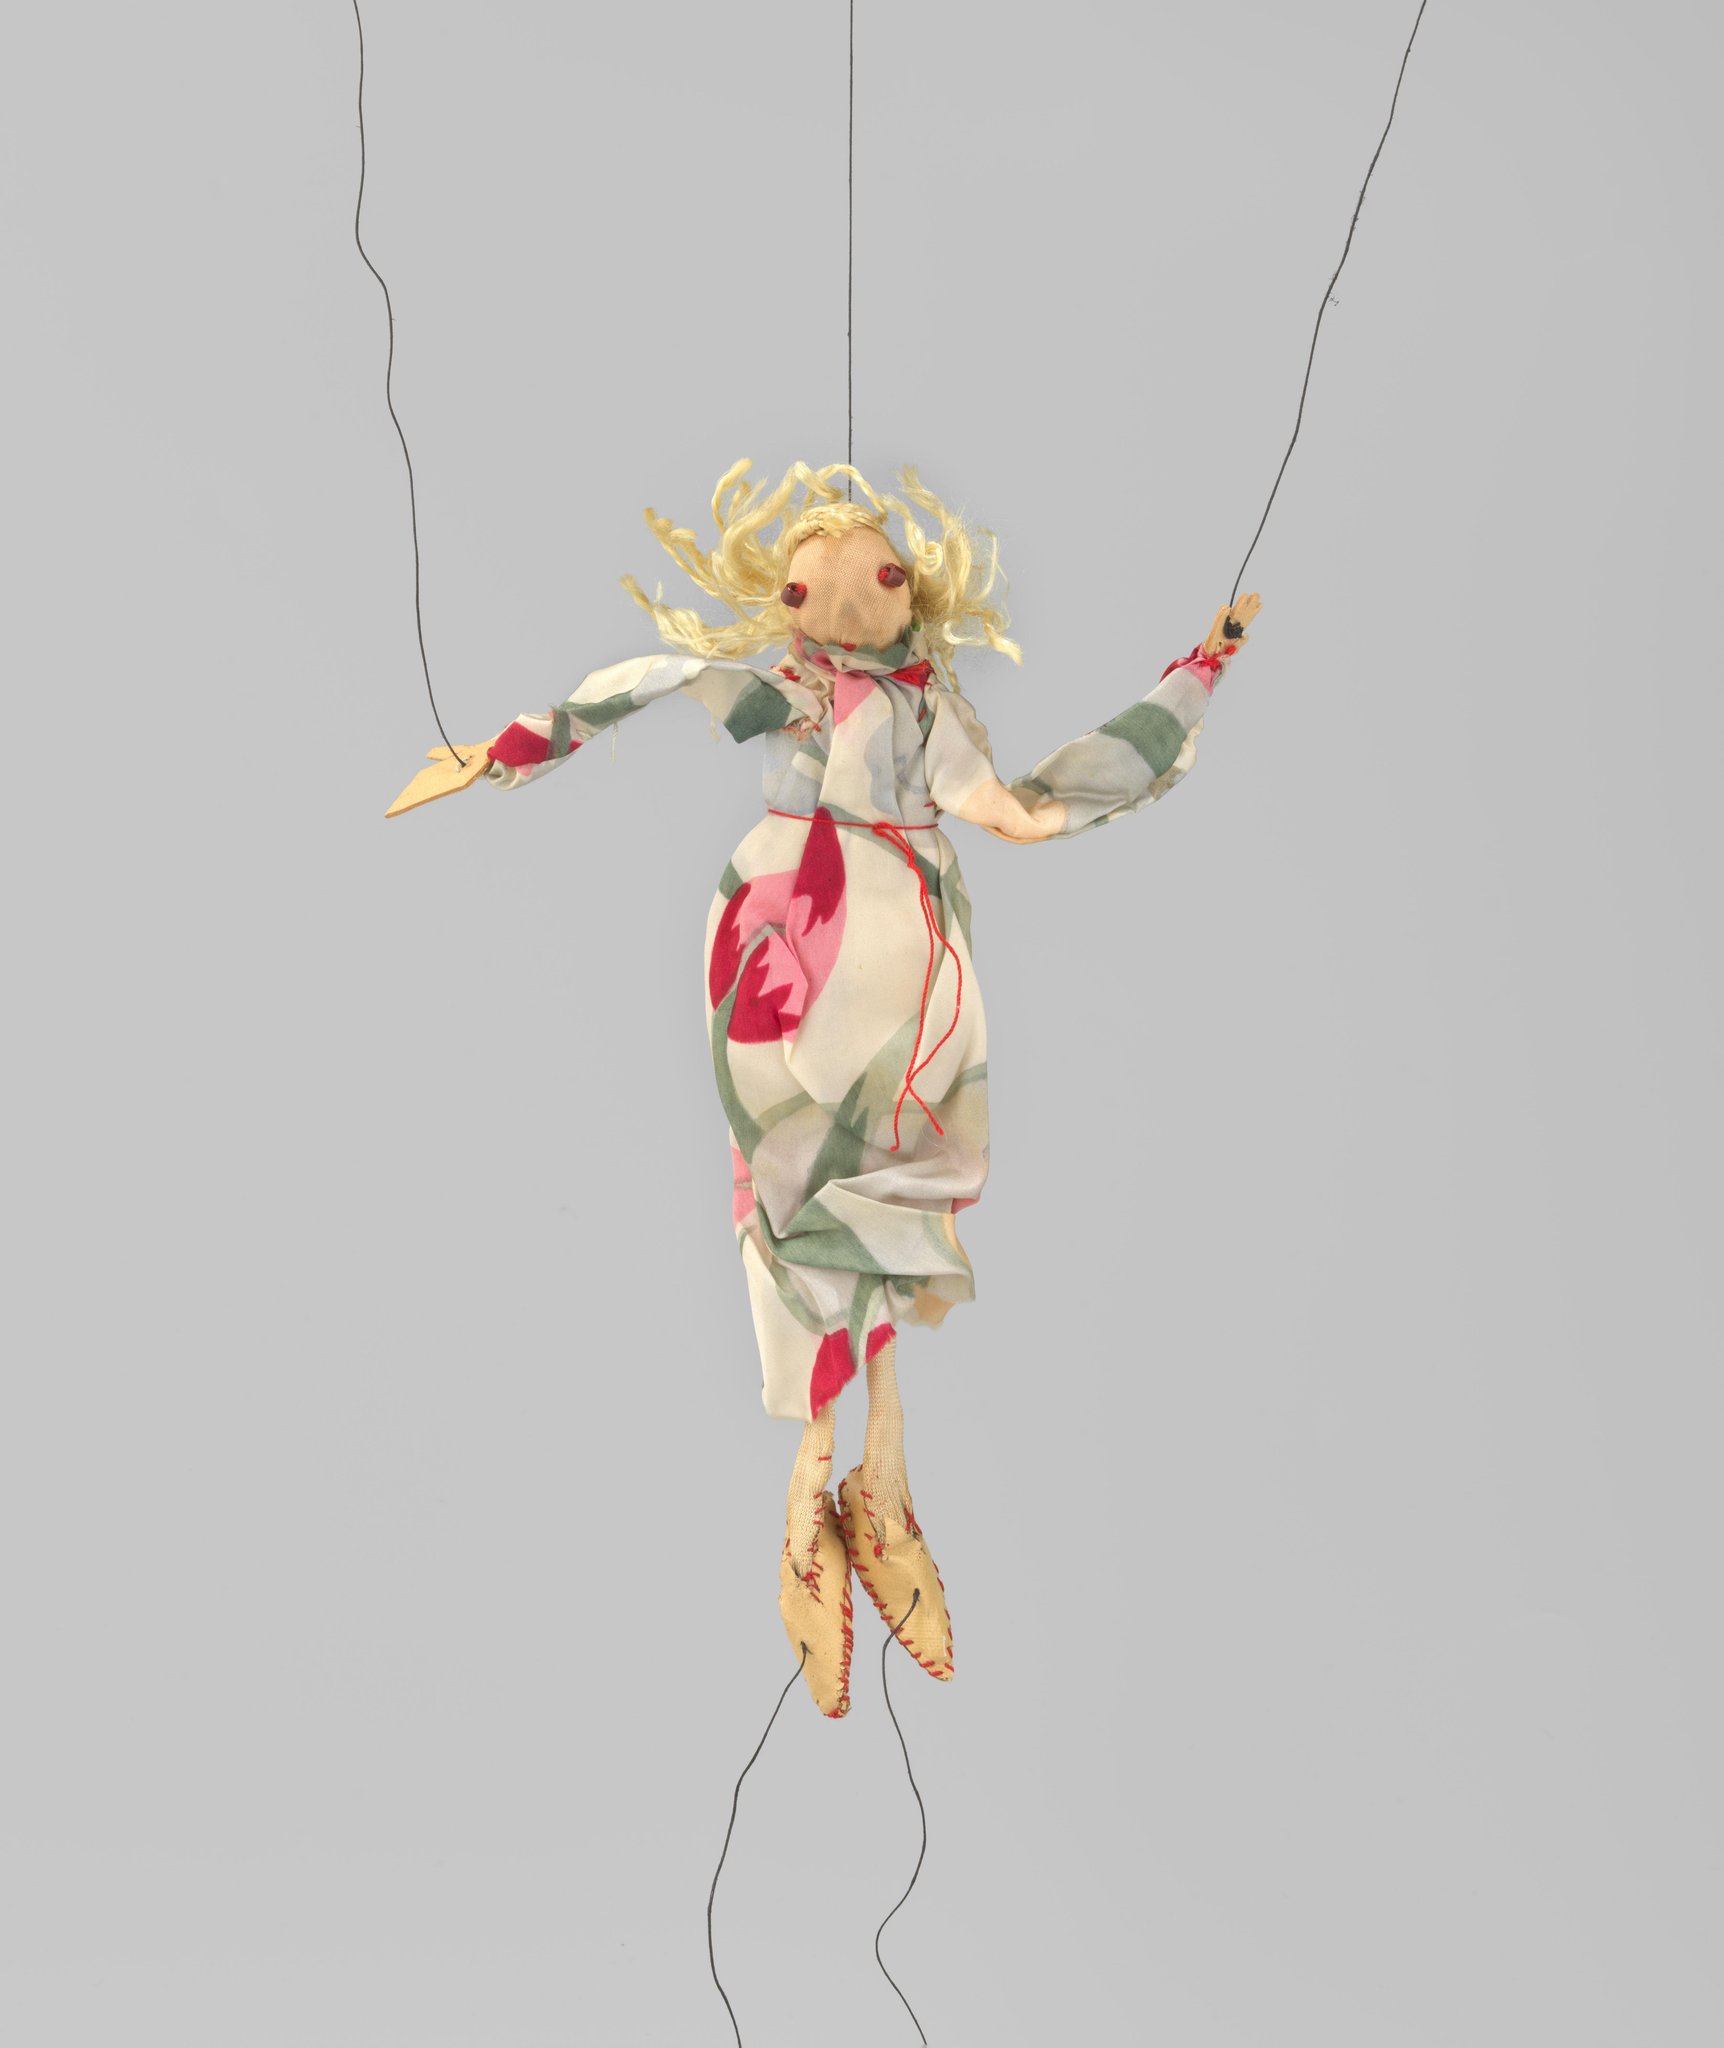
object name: puppet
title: Marionet, meisje met los vallend geel zijden haar gekleed in een jurk van zijden Wiener Werkstätte stof en schoenen van beige kunstleer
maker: ada helena hondius-crone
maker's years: 1893-1996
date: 1920-1930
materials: cardboard, clay, cotton, glass, leather, textile, silk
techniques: manufacturing, firing, weave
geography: amsterdam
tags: amsterdam, voorschoten, ada helena hondius-crone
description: Marionet, meisje met los vallend geel zijden haar gekleed in een jurk van zijden Wiener Werkstätte stof en schoenen van beige kunstleer. Hoofd van klei bekleed met zijden tricot waarop het haar in vlechten is genaaid, maar dat los over de schouders valt. Ogen van rode glazen kraaltjes en een geborduurde rode mond. Lange jurk van zijde - beige fond met een fantasie floraal motief in rood, roze, groen en grijsblauw - met lange mouwen, gerimpelde hals met ruche onder de kin en een ceintuur van rood draad om de taille. Handen geknipt uit karton. Lijf gevuld met stro, geen armen (handen zijn bevestigd aan de mouwen), ongevulde benen van kunstzijden tricot. Voeten van klei met schoenen van beige kunstleer gemaakt met steken van rood garen.